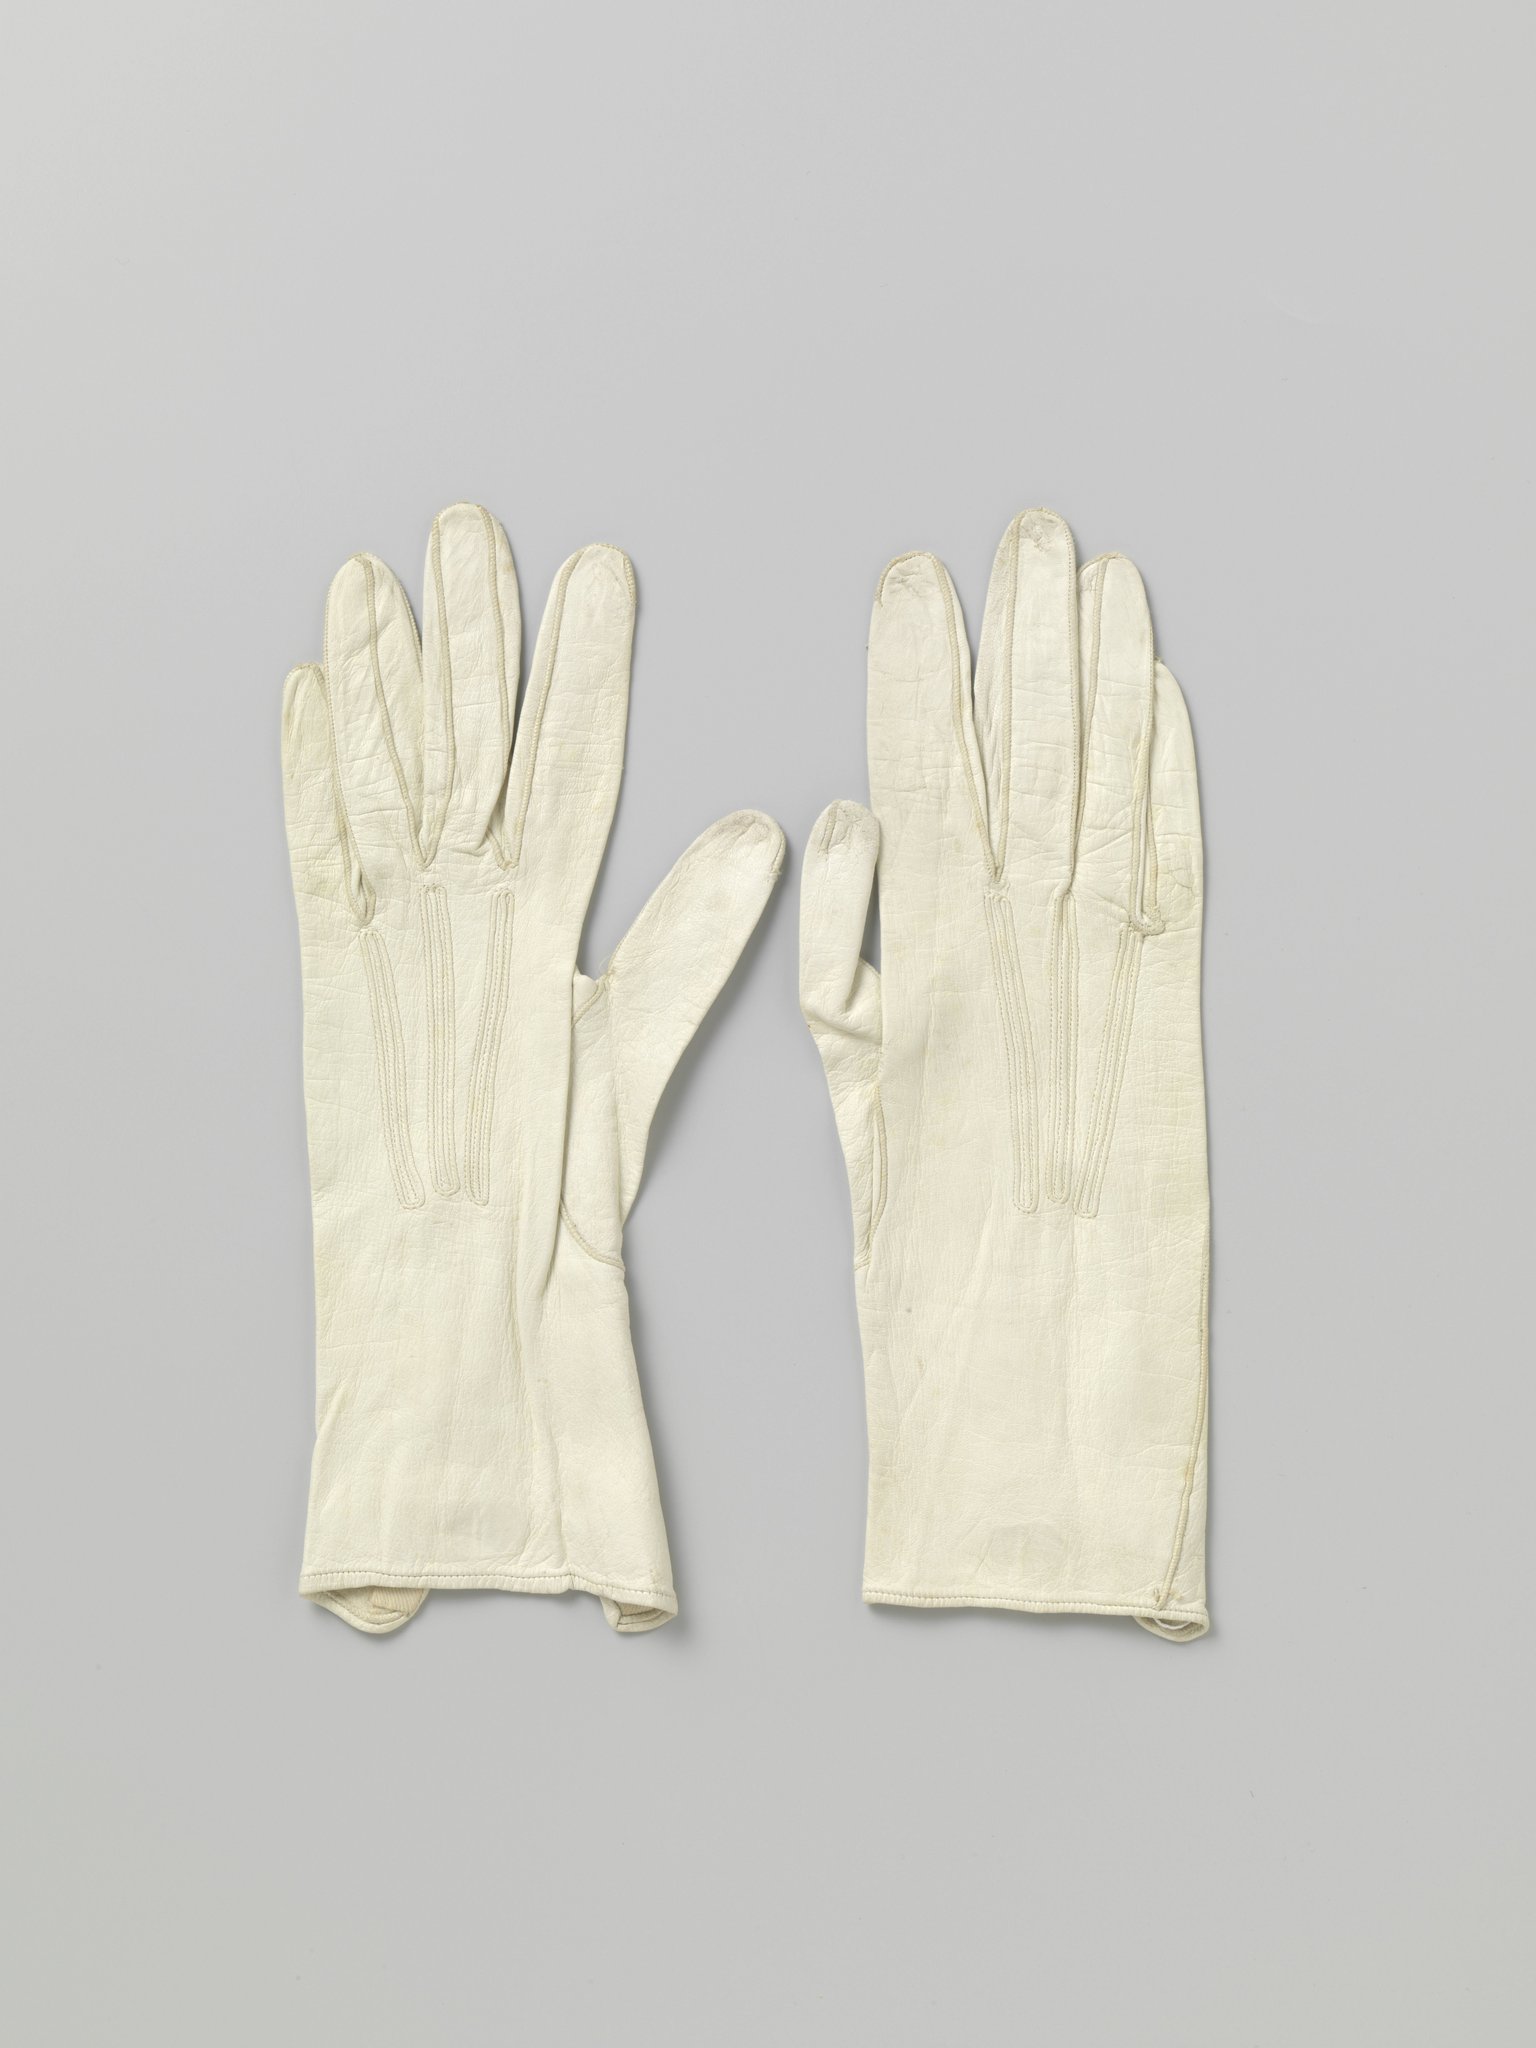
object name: clothing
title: Handschoen van leer met twee parelmoer drukknopen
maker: Anonymous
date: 1900-1950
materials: leather, mother of pearl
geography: netherlands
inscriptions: : ‘cijfers’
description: Rechter handschoenen van leer met twee parelmoer drukknopen en op de rug drie uitstralende koorden.